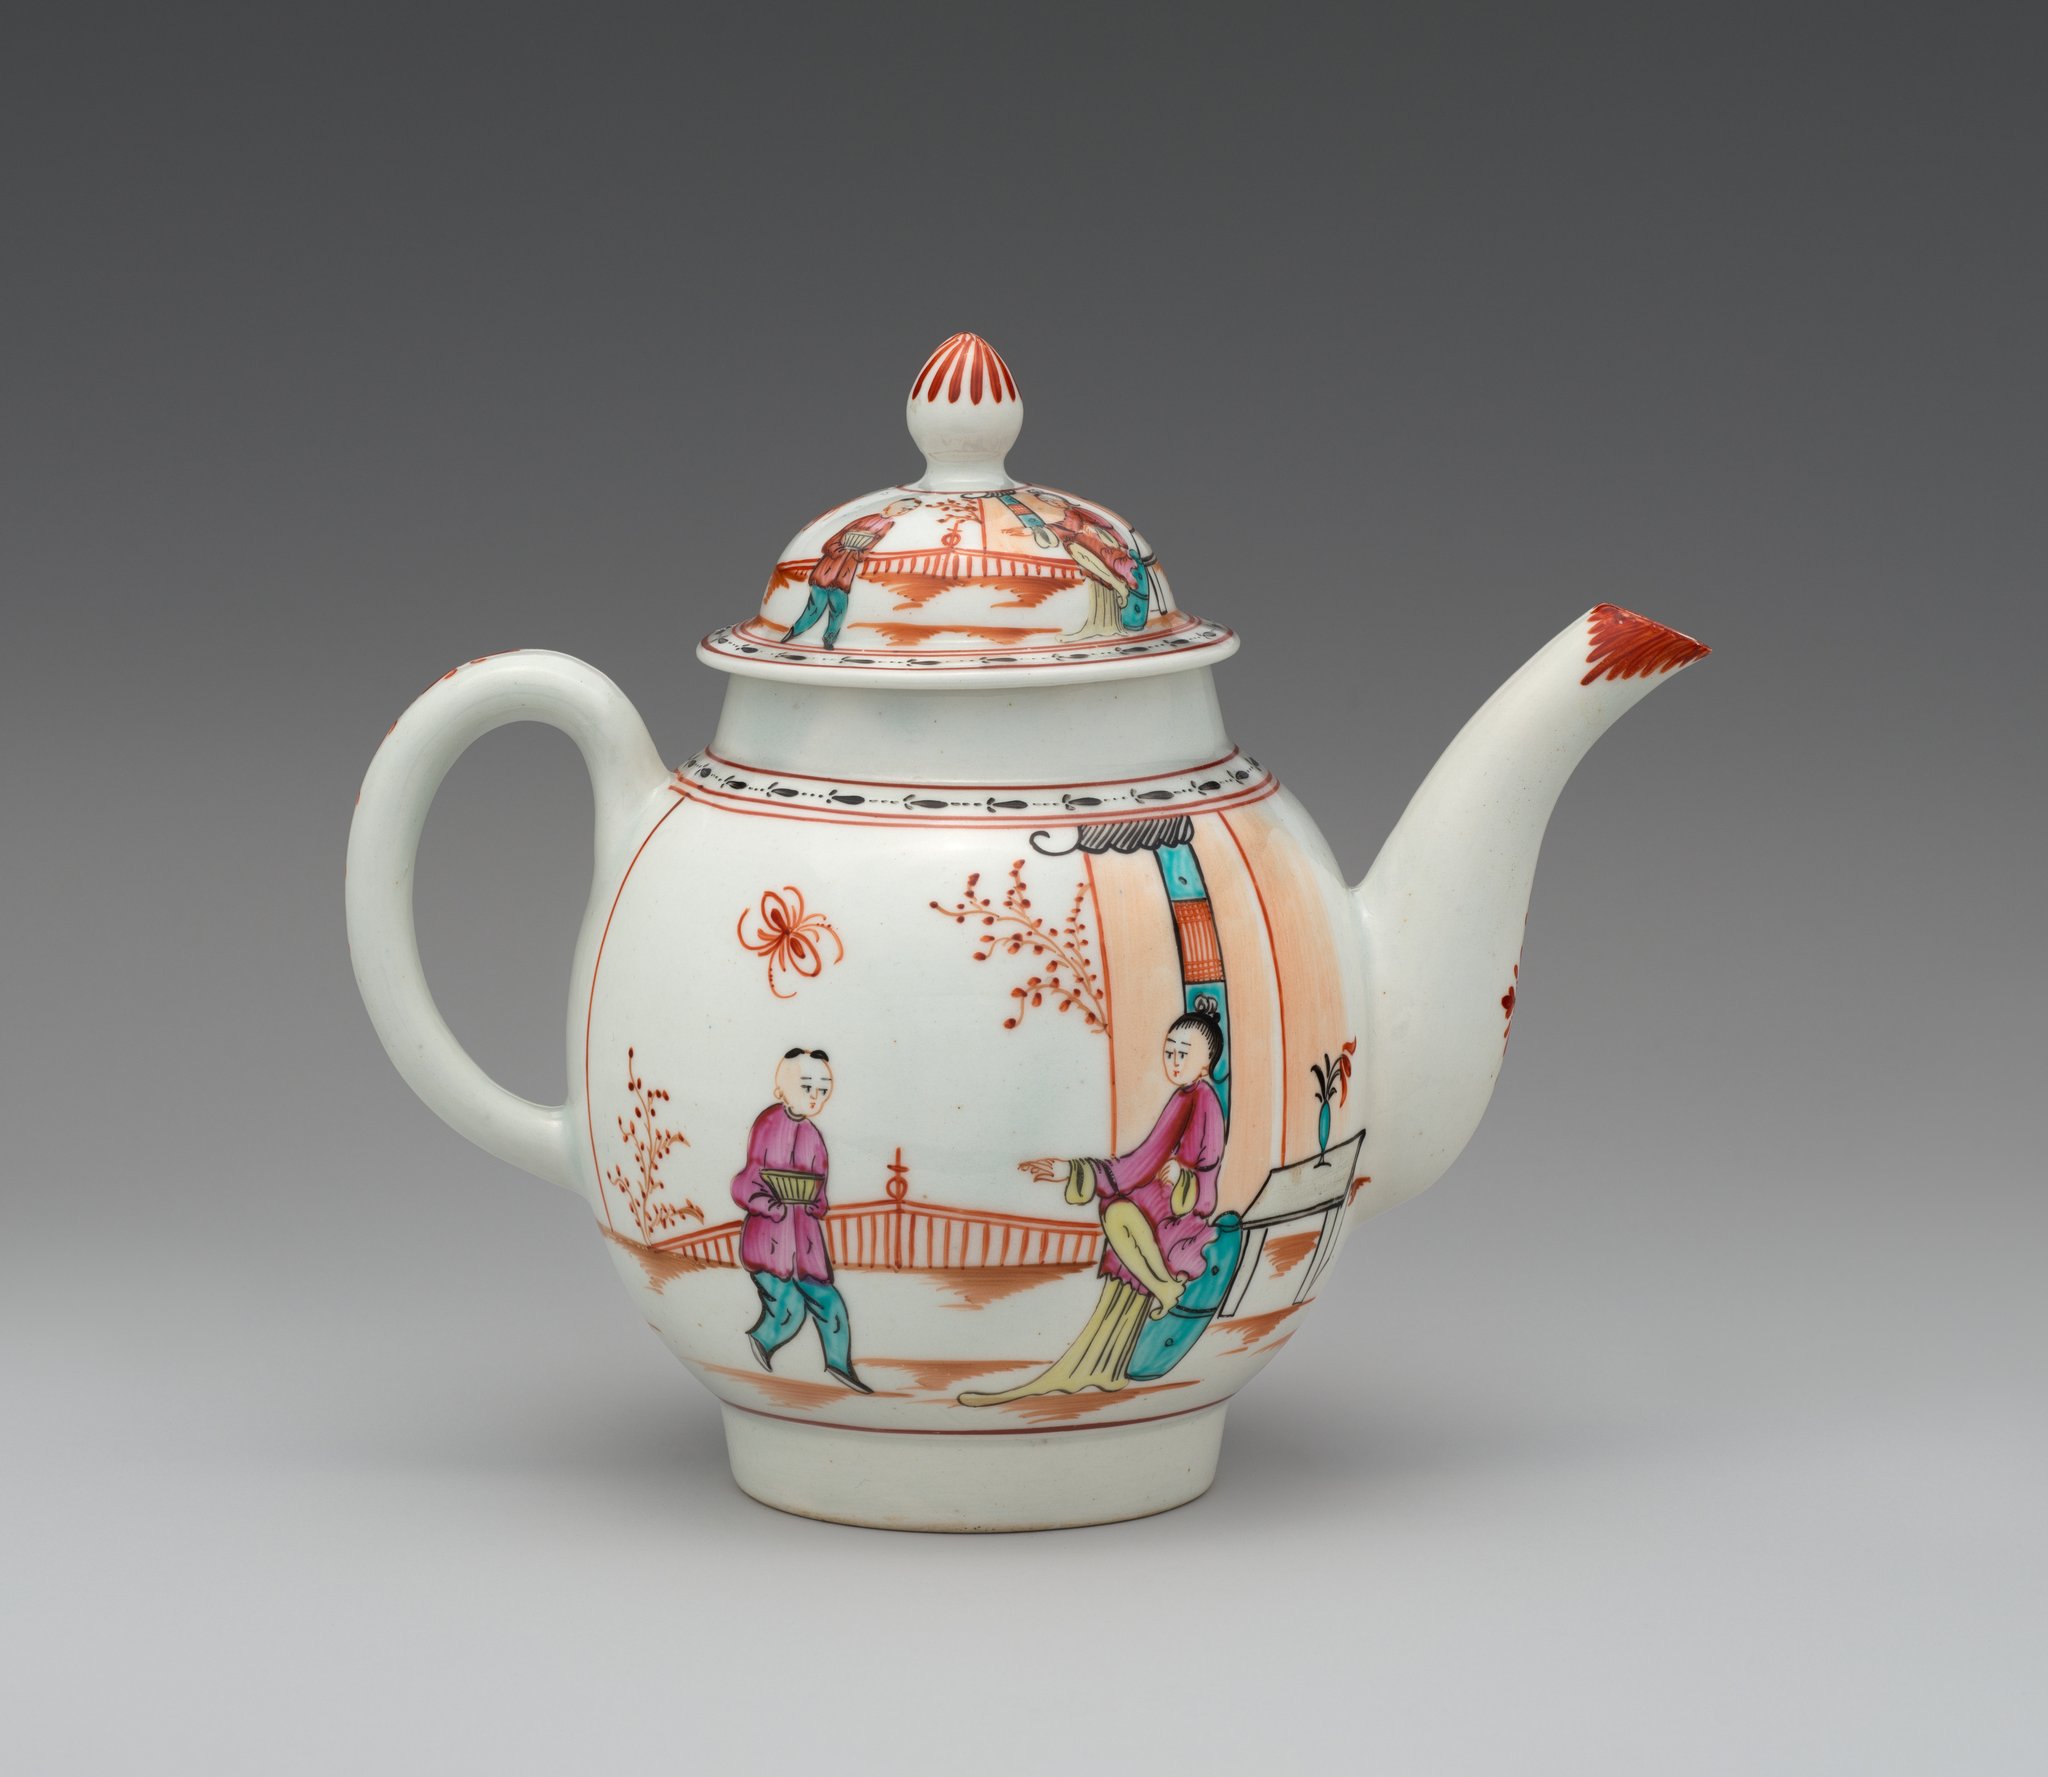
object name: teapot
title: Teapot (part of a service)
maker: lowestoft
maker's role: factory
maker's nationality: british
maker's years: 1757-1803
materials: soft paste porcelain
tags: boys,women